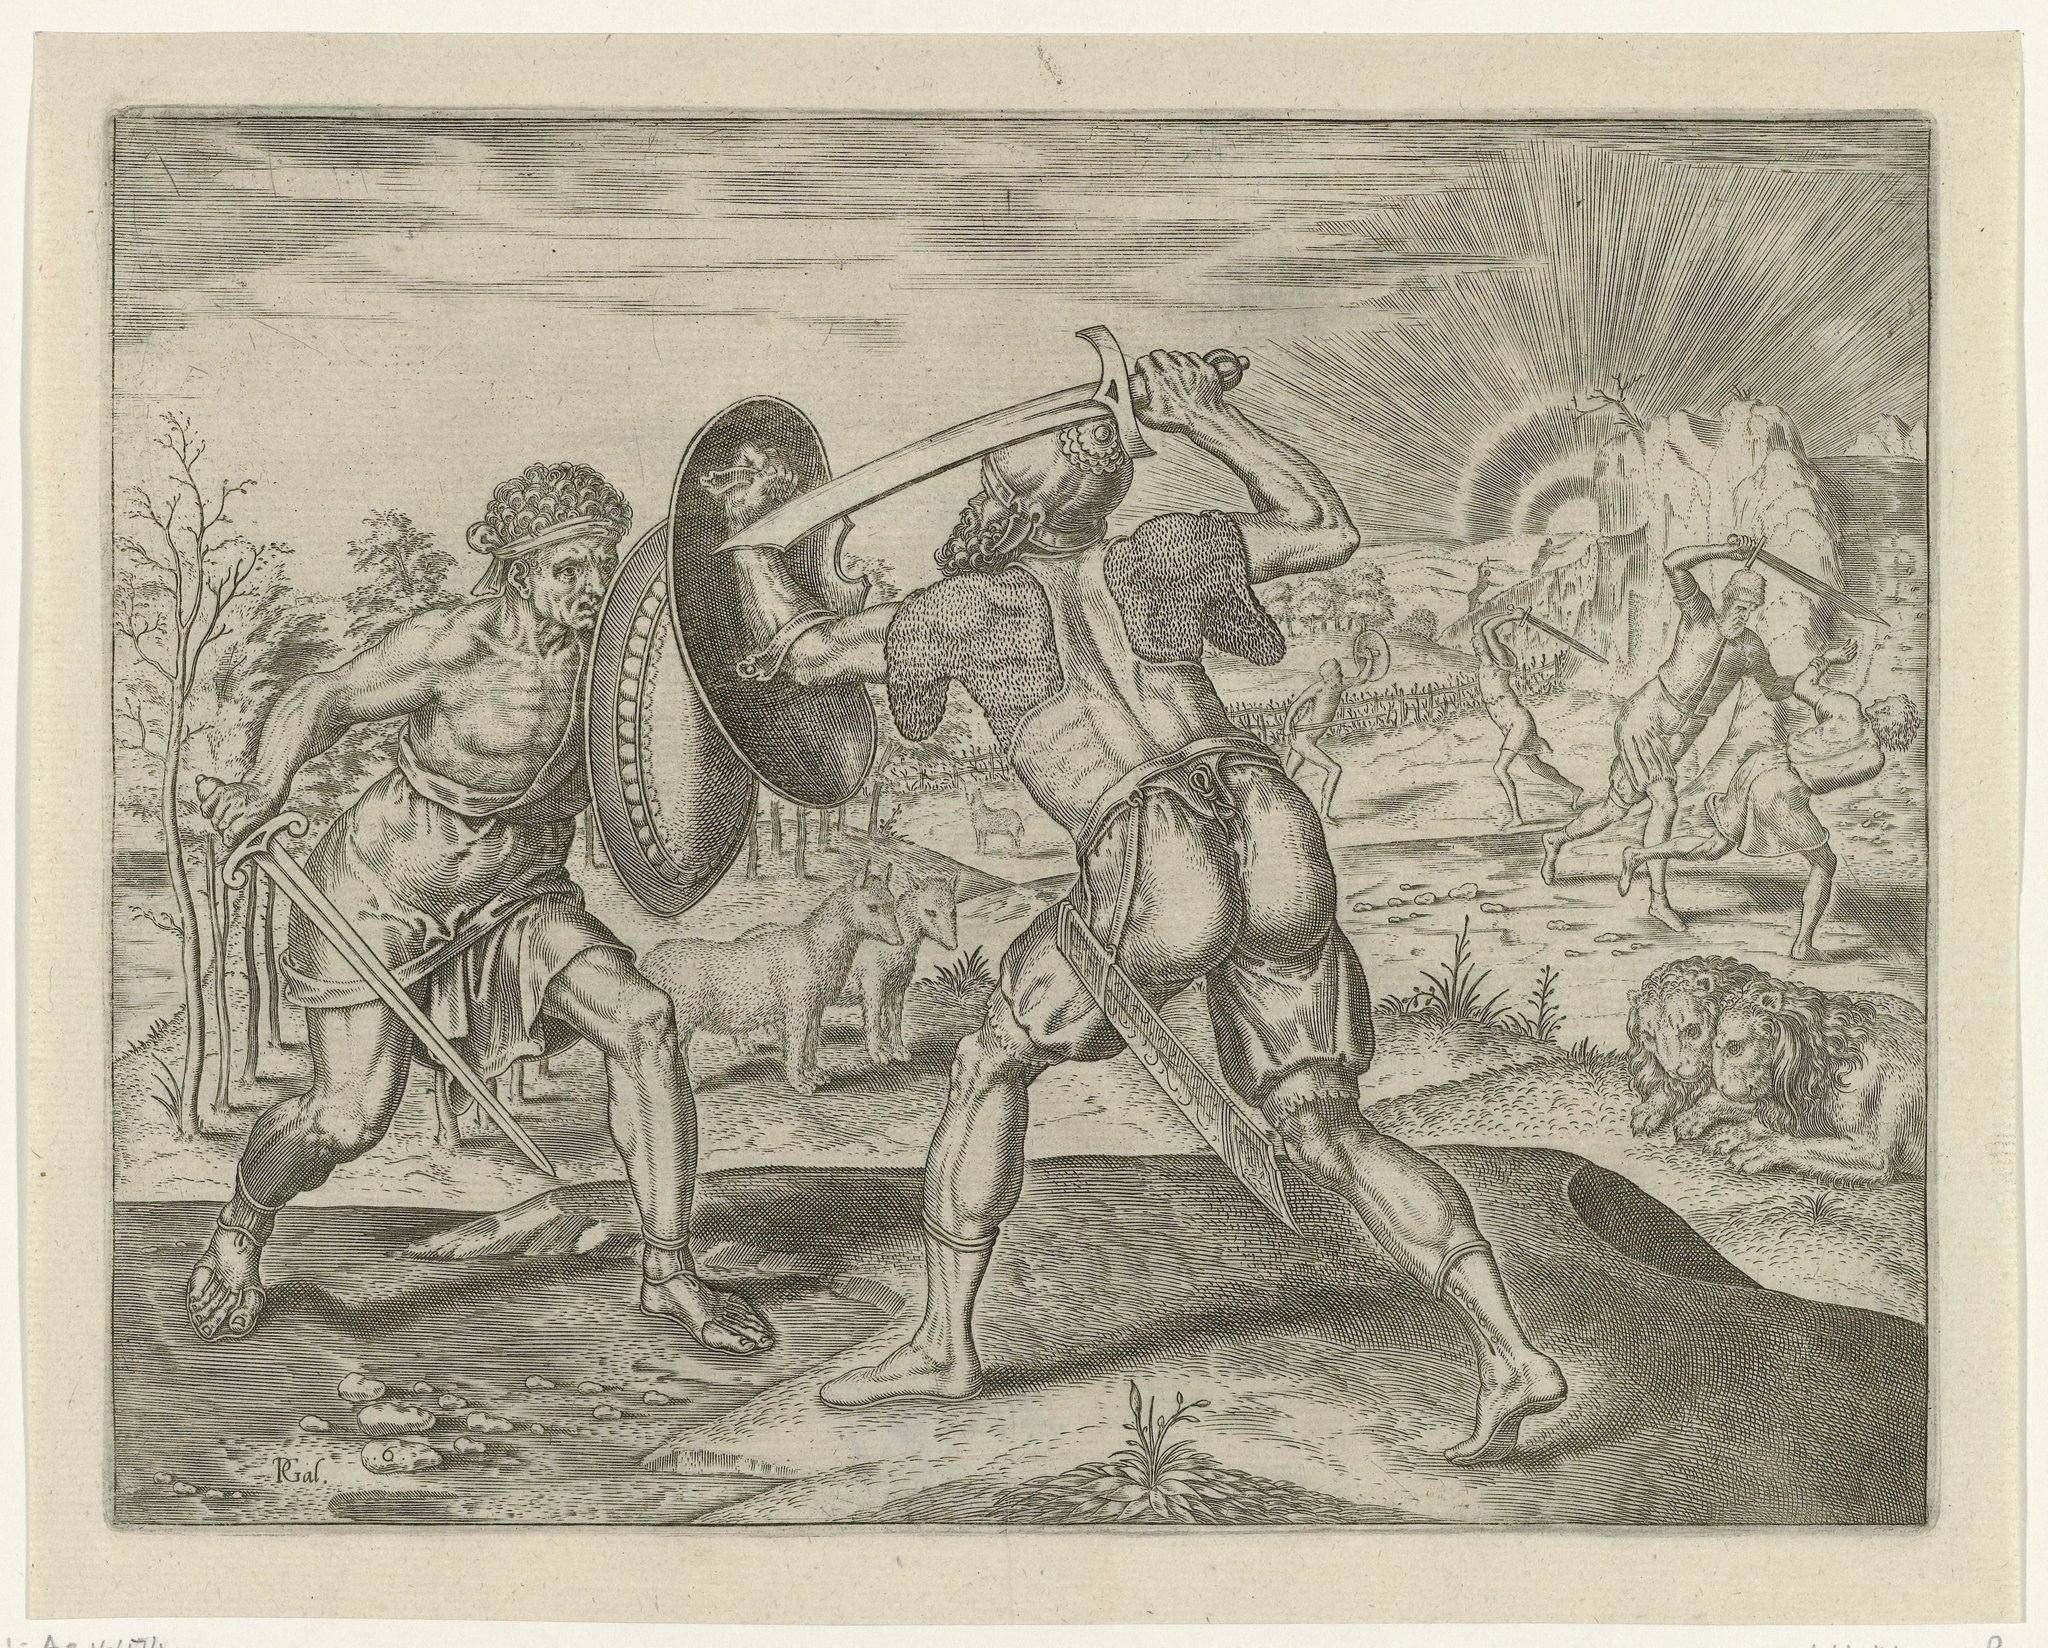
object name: print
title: Ellende van het menselijk bestaan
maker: philips galle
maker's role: print maker, publisher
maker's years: 1537-1612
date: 1563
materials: paper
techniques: engraving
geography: haarlem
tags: beasts of prey, predatory animals: bear, violent death, being killed; being mishandled and maltreated; seeking death, beasts of prey, predatory animals: lion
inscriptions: collector's mark: Lugt 2228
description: In de voorgrond vechten twee mannen tegen elkaar. In de achtergrond zijn ook mannen aan het vechten. Twee leeuwen en twee beren zitten vreedzaam naast elkaar. Dieren vechten nooit tegen hun soortgenoten, maar de mens grijpt snel naar de wapens om zijn eigen soortgenoten ten gronde te richten. De prent is deel van een serie over de ellende van het menselijk bestaan.